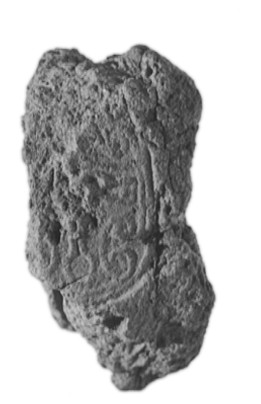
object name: sealing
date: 2030-1640 BCE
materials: clay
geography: egypt